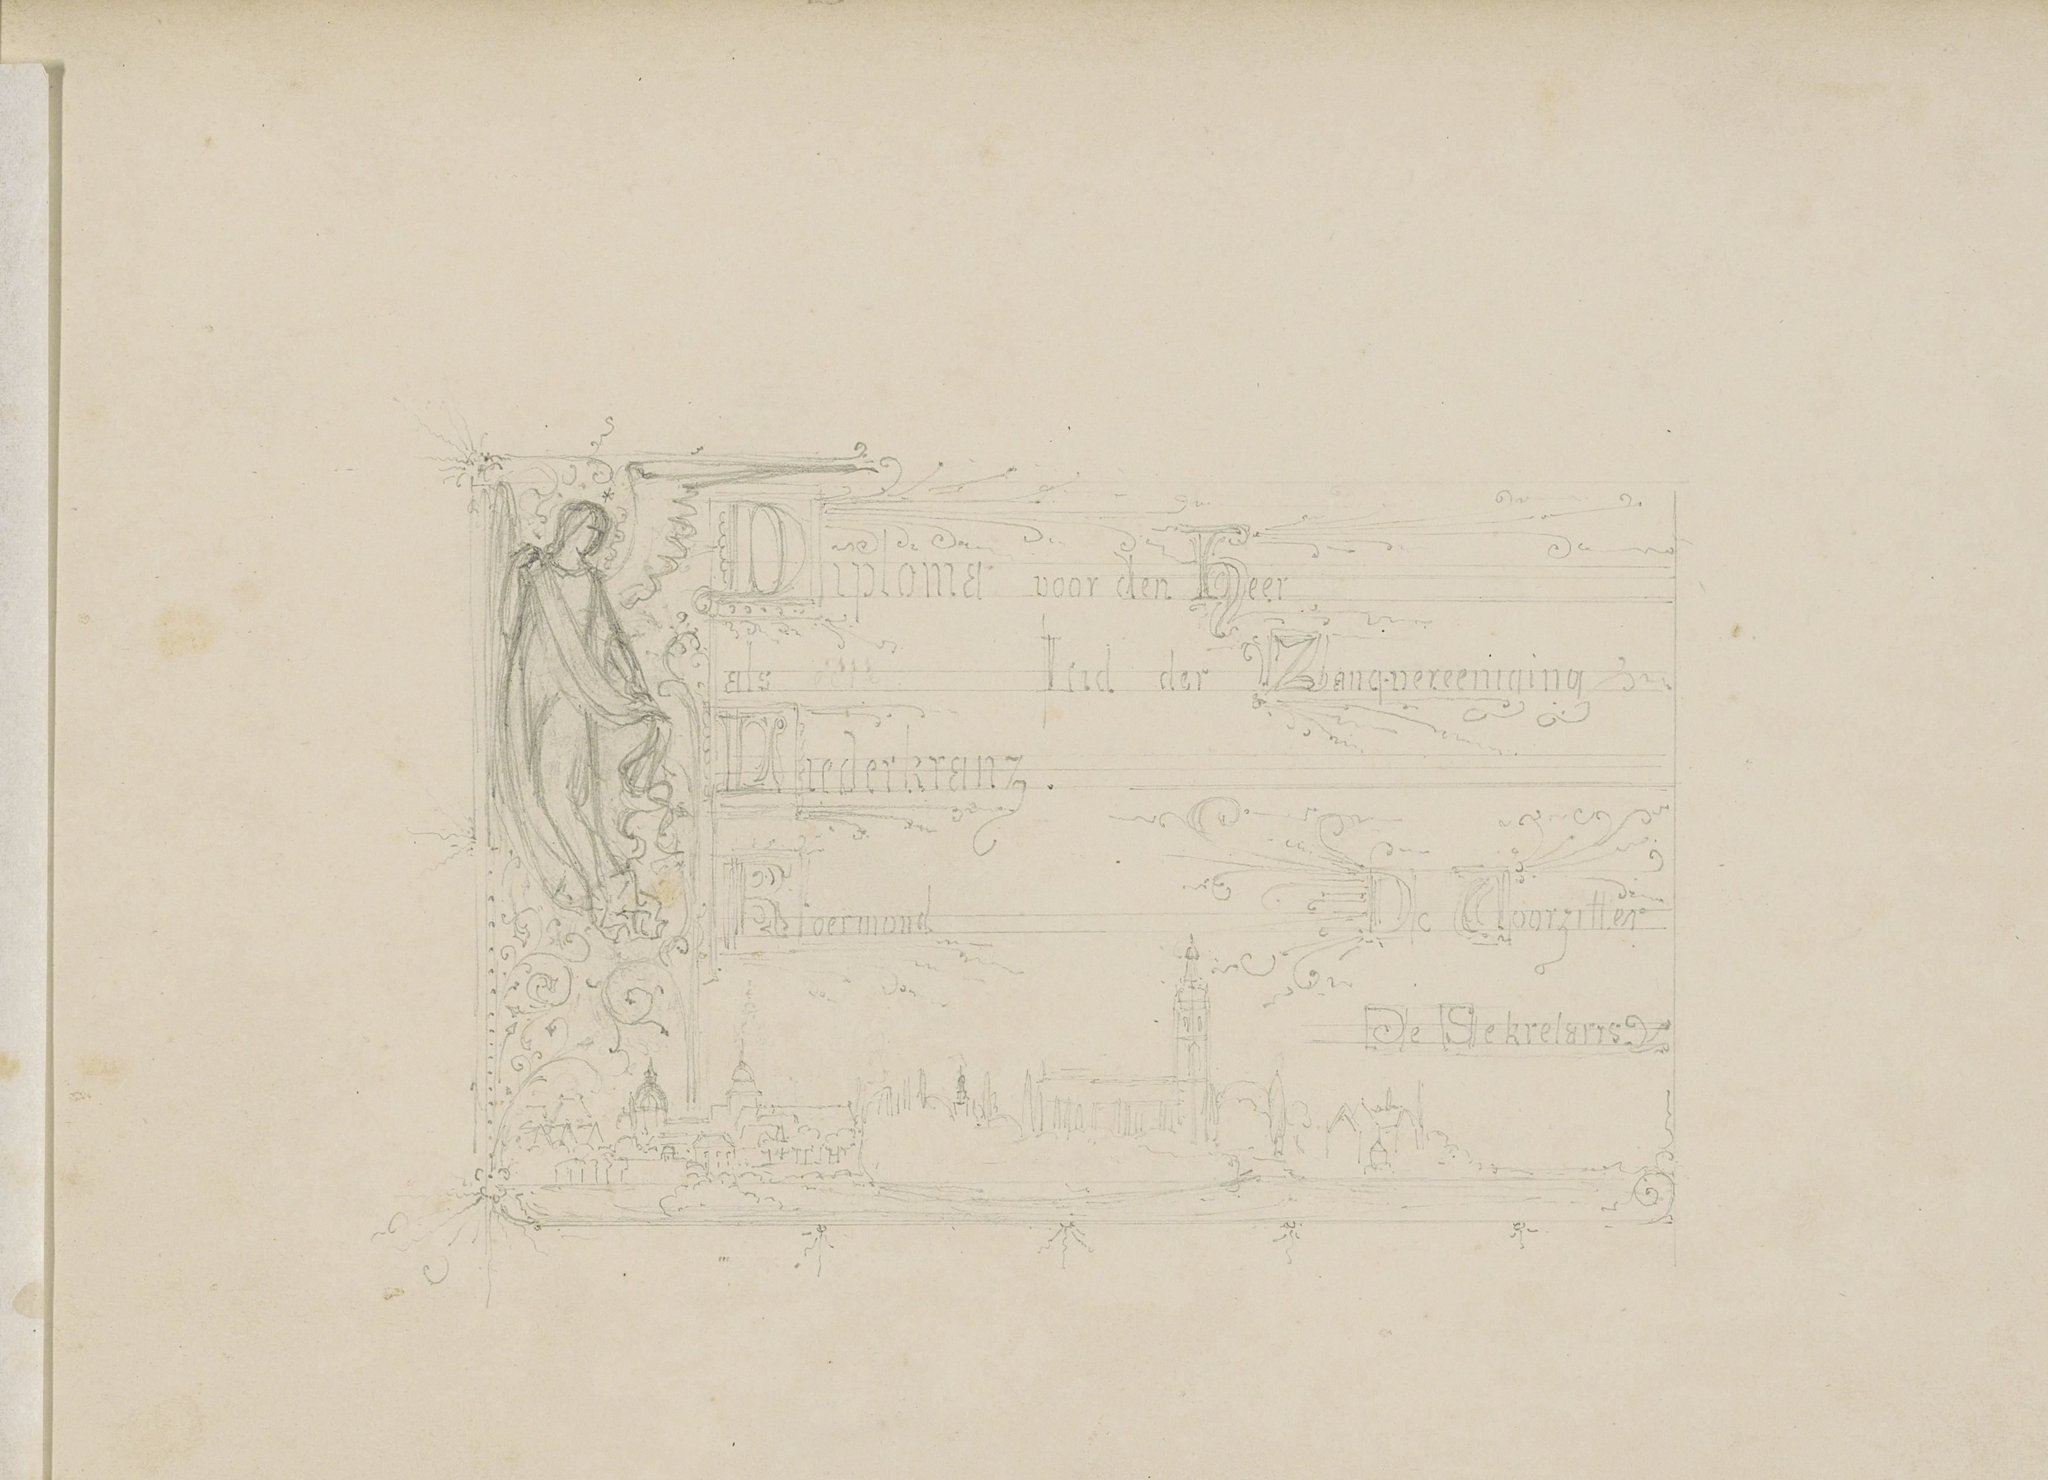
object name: sketchbook leaf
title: Ontwerp voor een diploma van de zangvereniging 'Liederkranz' te Roermond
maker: pierre joseph hubert cuypers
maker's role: draughtsman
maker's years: 1827-1921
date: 1857-1859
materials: paper, pencil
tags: handwriting, written text, fancy letters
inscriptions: annotation: ‘Diploma voor den heer/ Lid der Zangvereniging/ Liederkranz/ Roermond/ De Voorzitter/ De Sekretaris’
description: Blad 22 recto uit een schetsboek met 77 bladen.